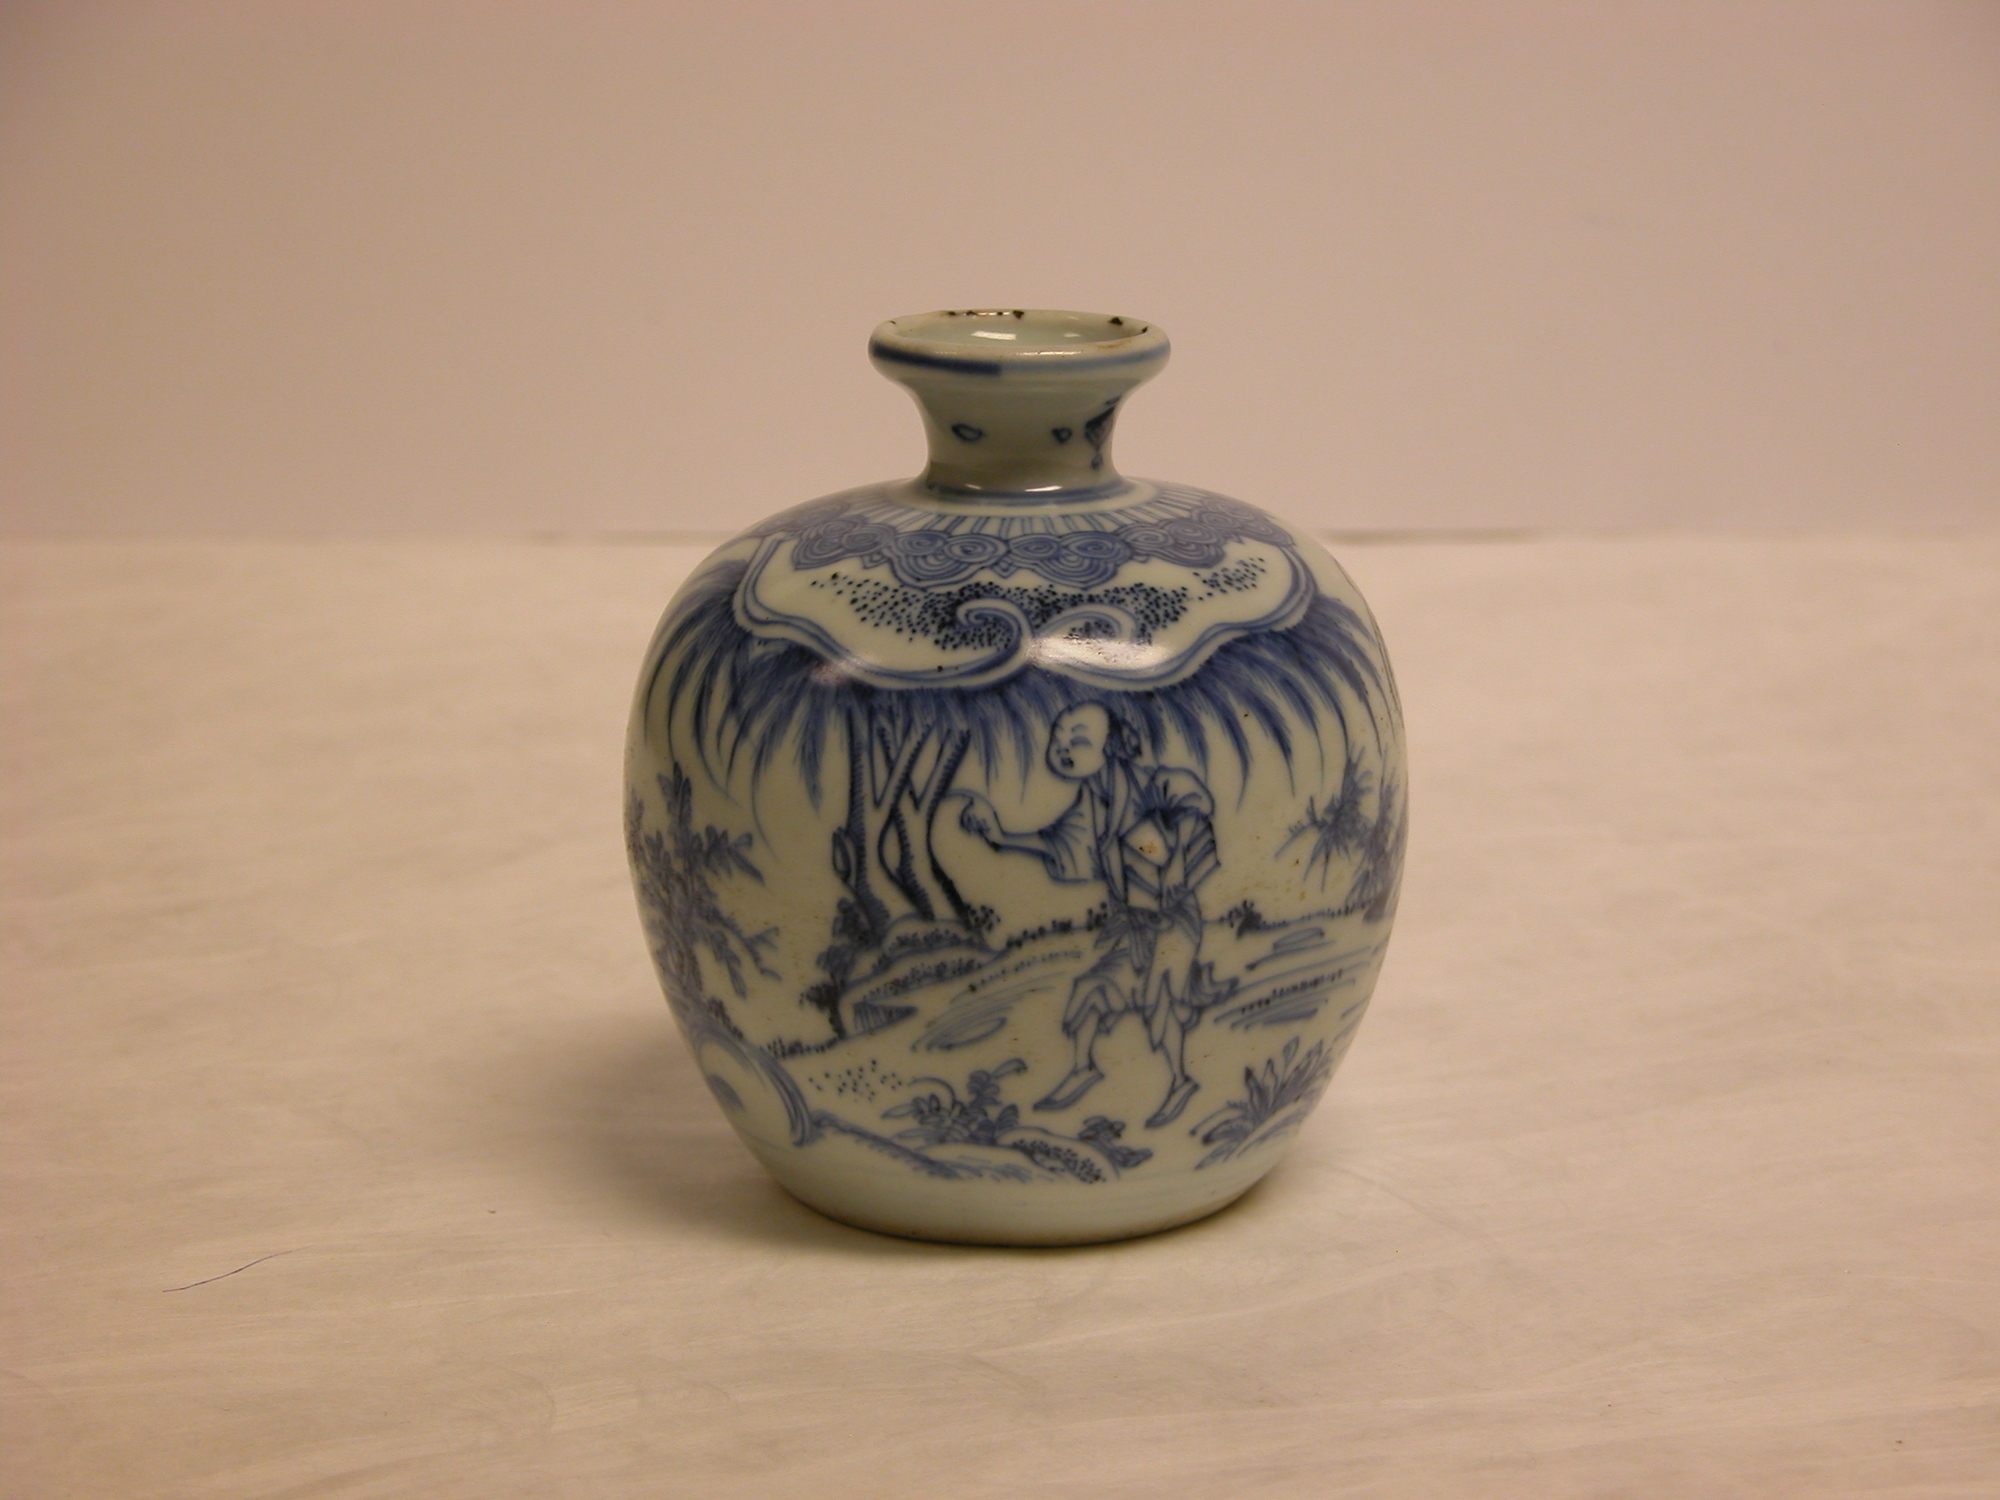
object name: vase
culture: chinese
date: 1465-1487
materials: porcelain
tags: men,trees